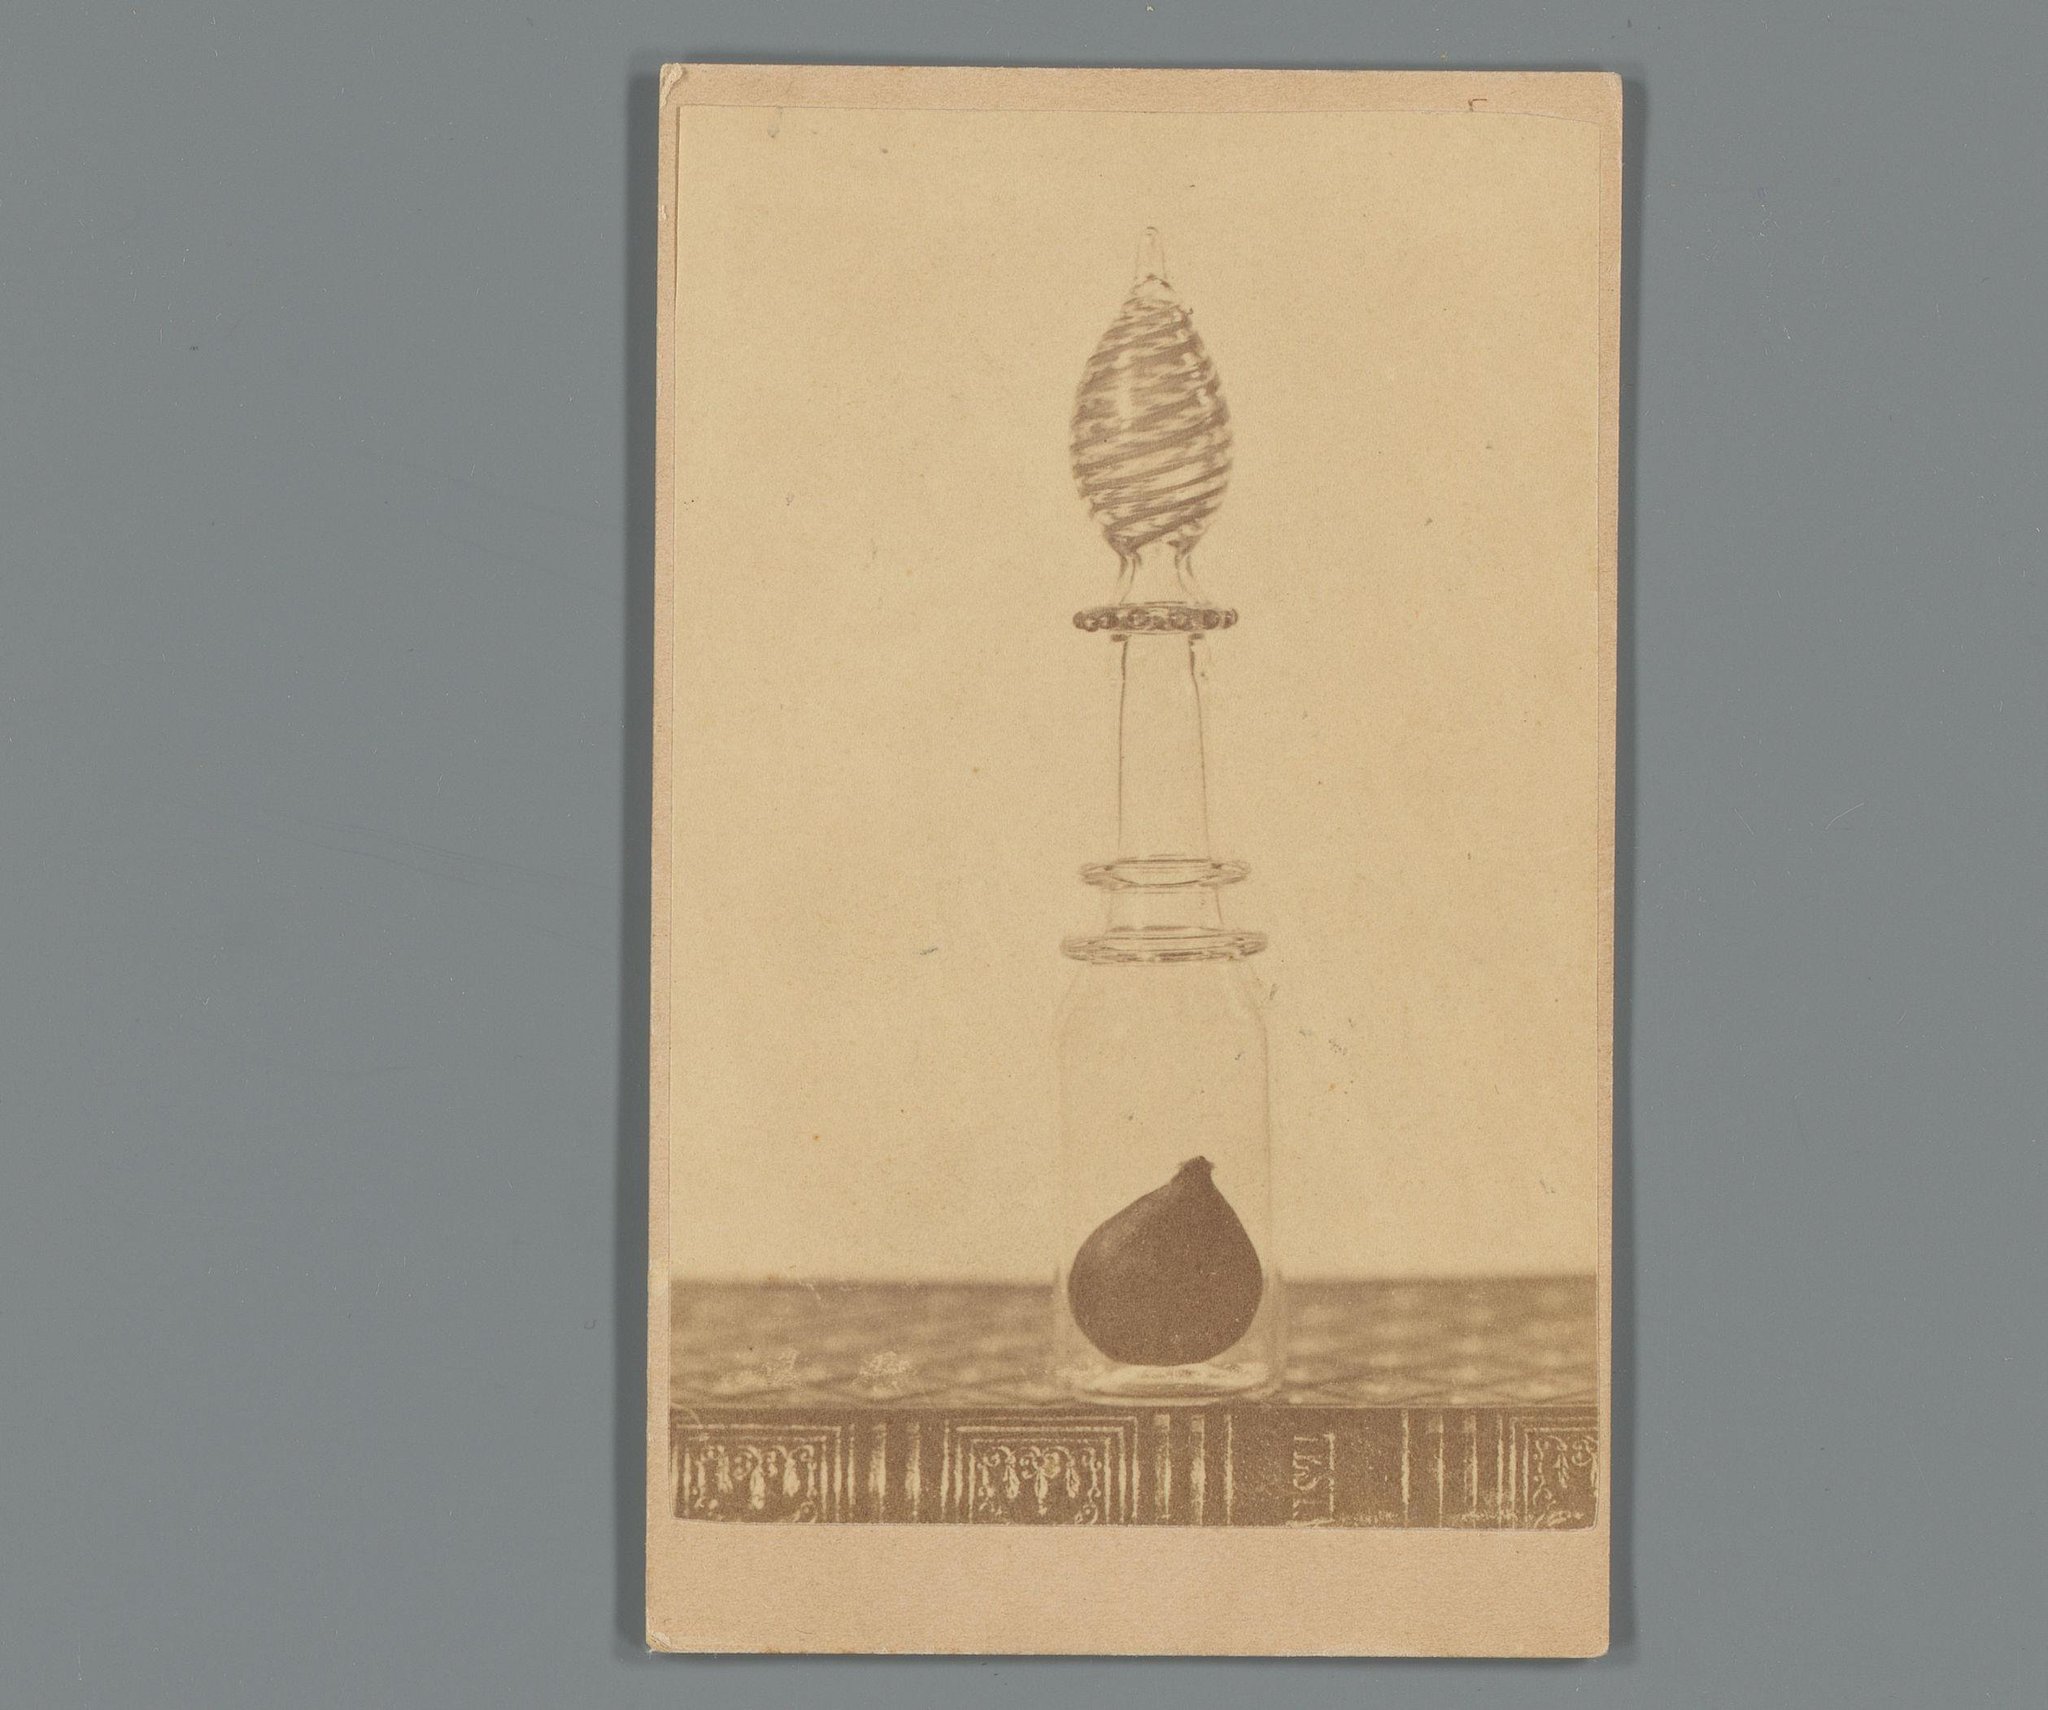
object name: photograph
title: Vaas met kastanje als reclame voor de Congregational Sabbath School and Public Society in Boston, Massachusetts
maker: james wallace black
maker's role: fotograaf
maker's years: 1823-1896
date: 1850-1915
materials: cardboard, photographic support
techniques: albumen print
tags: advertising, sabbath ~ jewish religion, fruits: chestnut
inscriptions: inscription: ‘(...)/ Photographed by Black, 163 & 173 Washington St., Boston.’